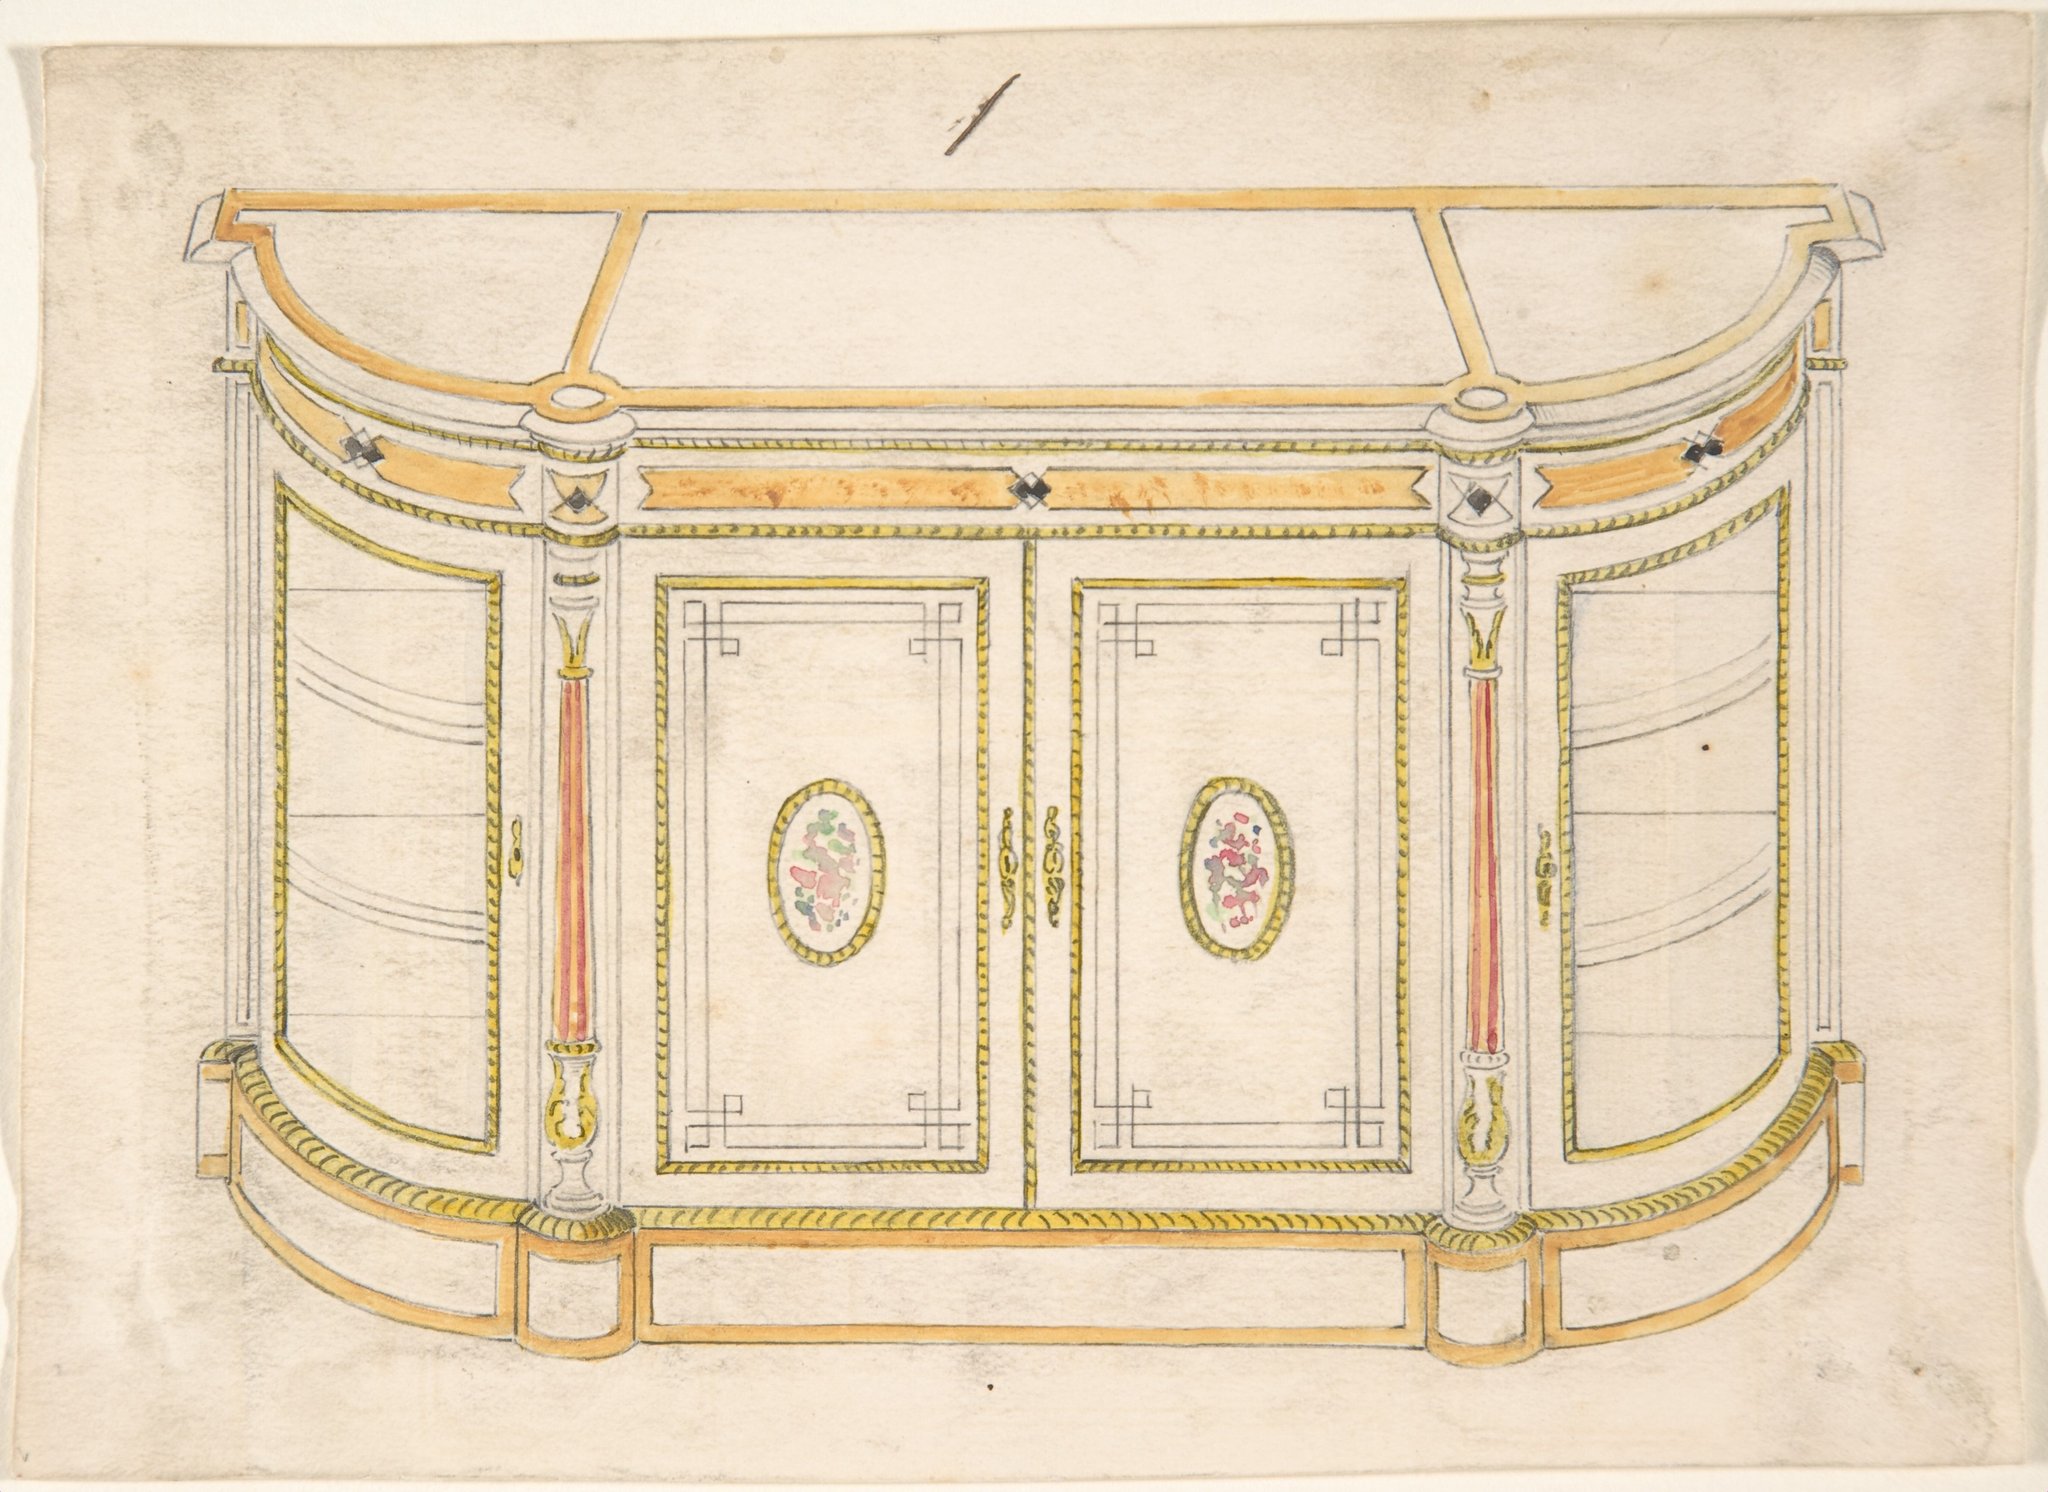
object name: drawing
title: Cabinet Design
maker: anonymous, british, 19th century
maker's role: artist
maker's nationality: british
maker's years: 1800-1900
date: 1801-1900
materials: graphite, ink, watercolor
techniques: pen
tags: cabinets